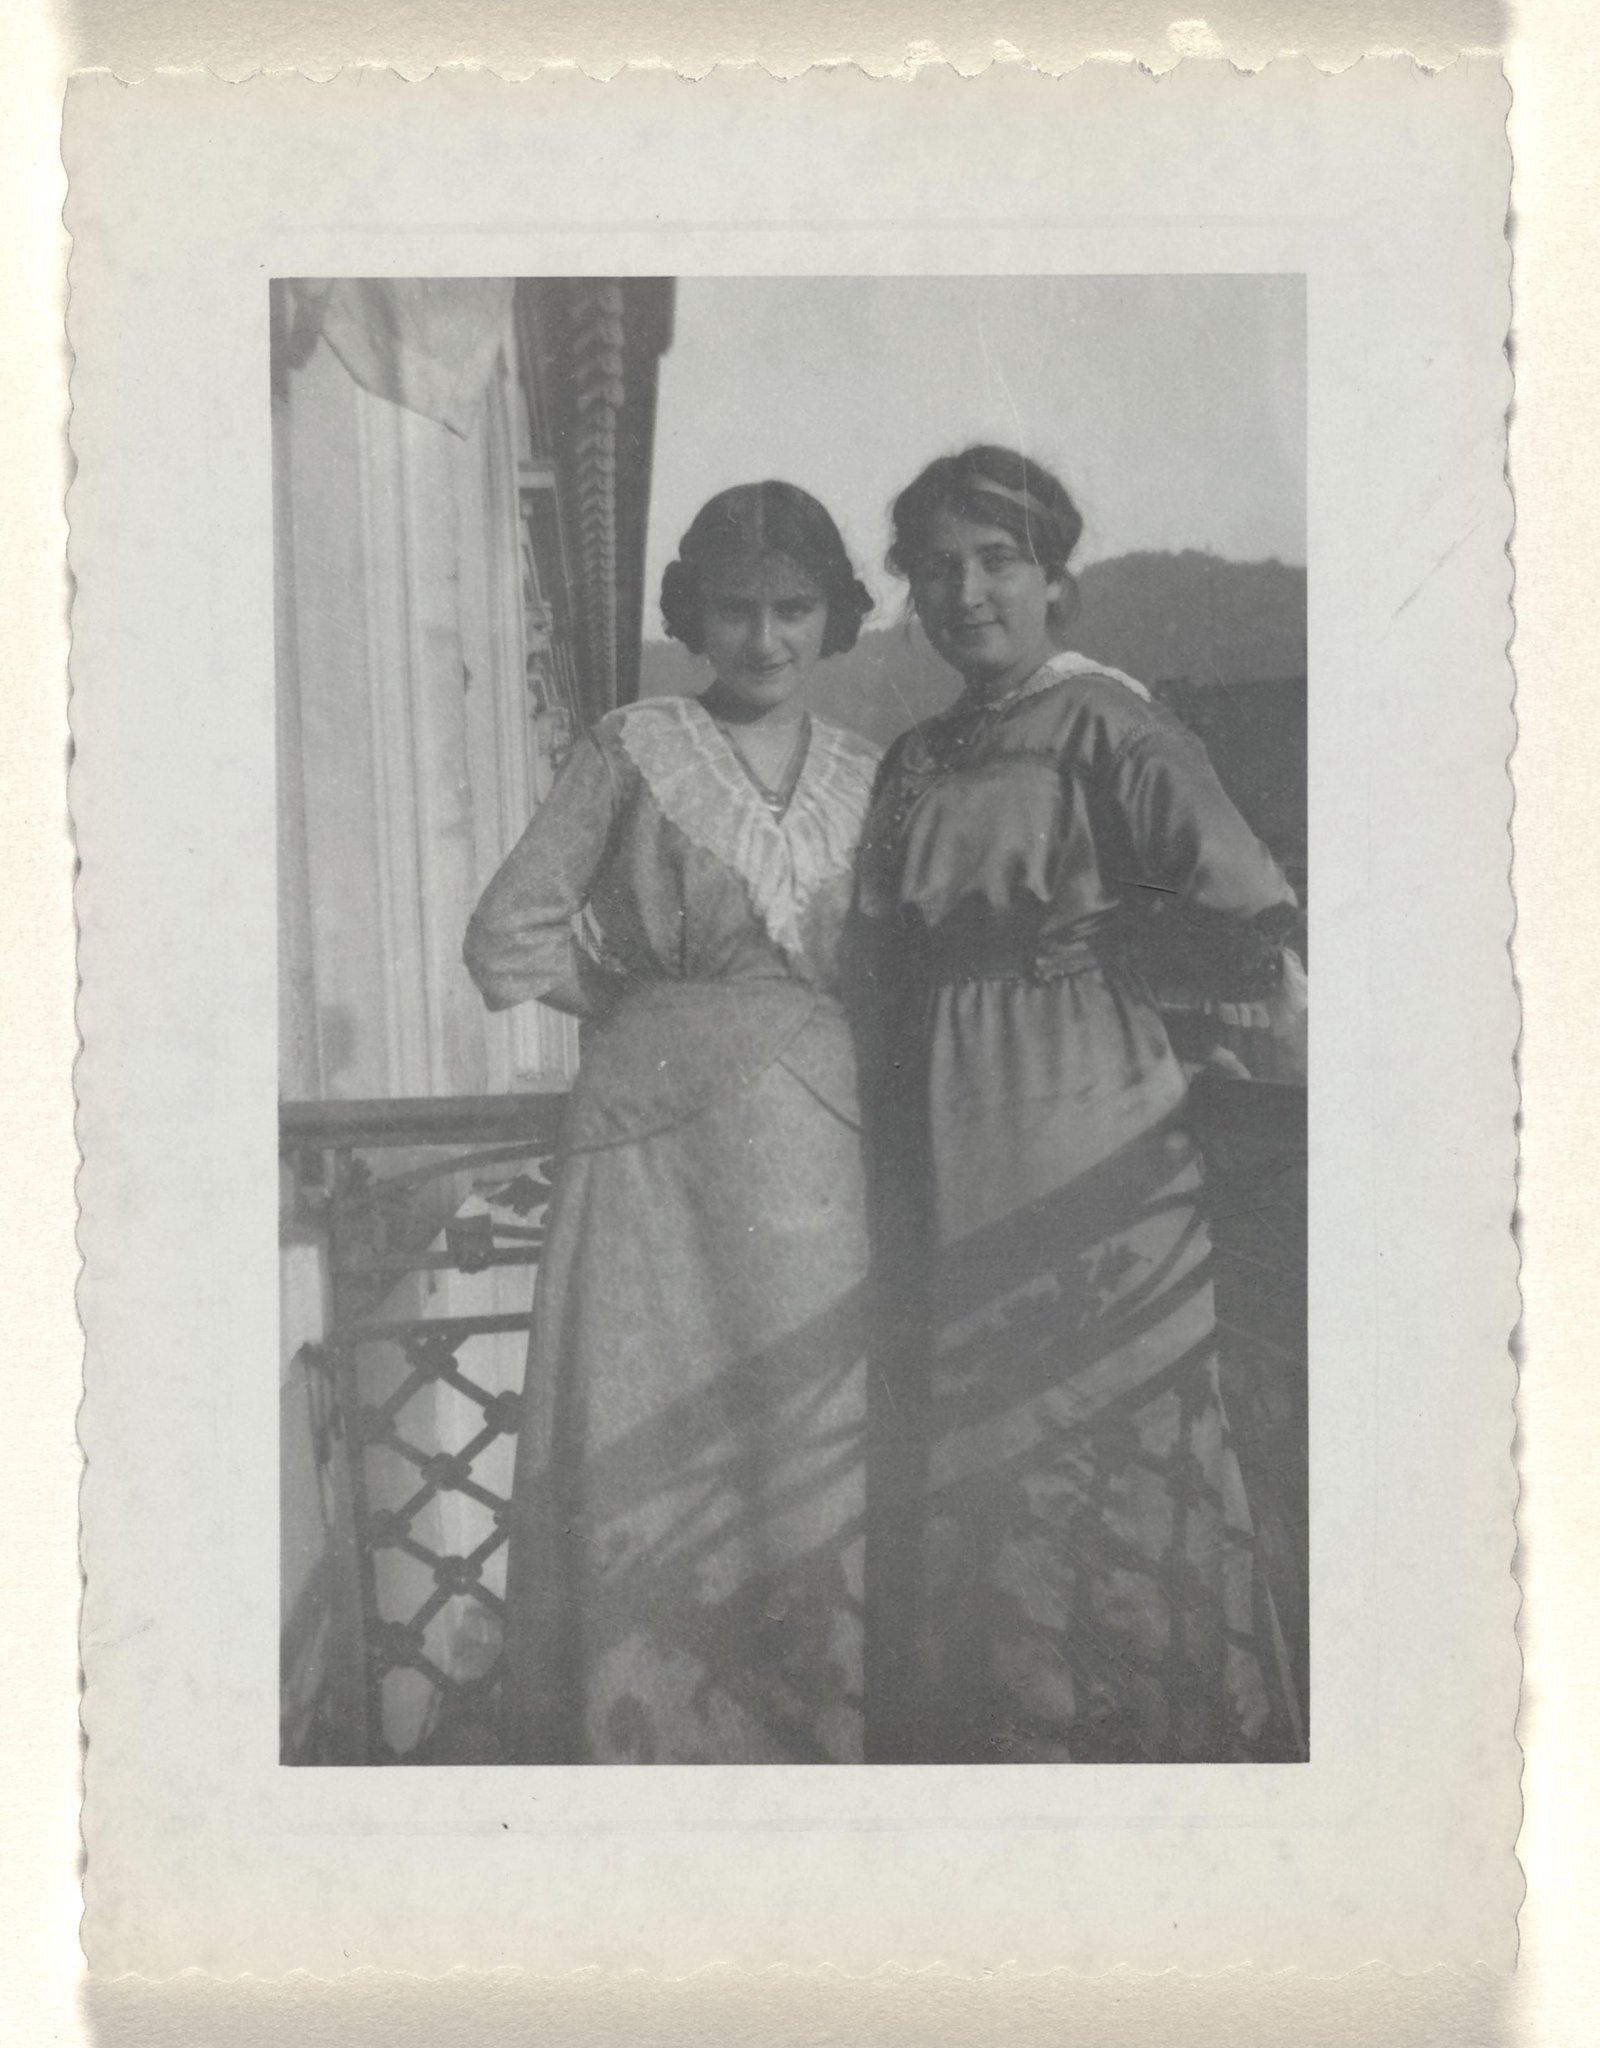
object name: photograph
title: Else Wachenheimer-Moos als jonge vrouw met een onbekende vrouw staande op een balkon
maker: Anonymous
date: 1914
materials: photographic support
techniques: gelatin silver print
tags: else wachenheimer-moos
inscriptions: inscription: ‘mutter Else mit meiner Schwester Lisa auf einer Besuchsreise in Freiburg auf unseren Balkon’